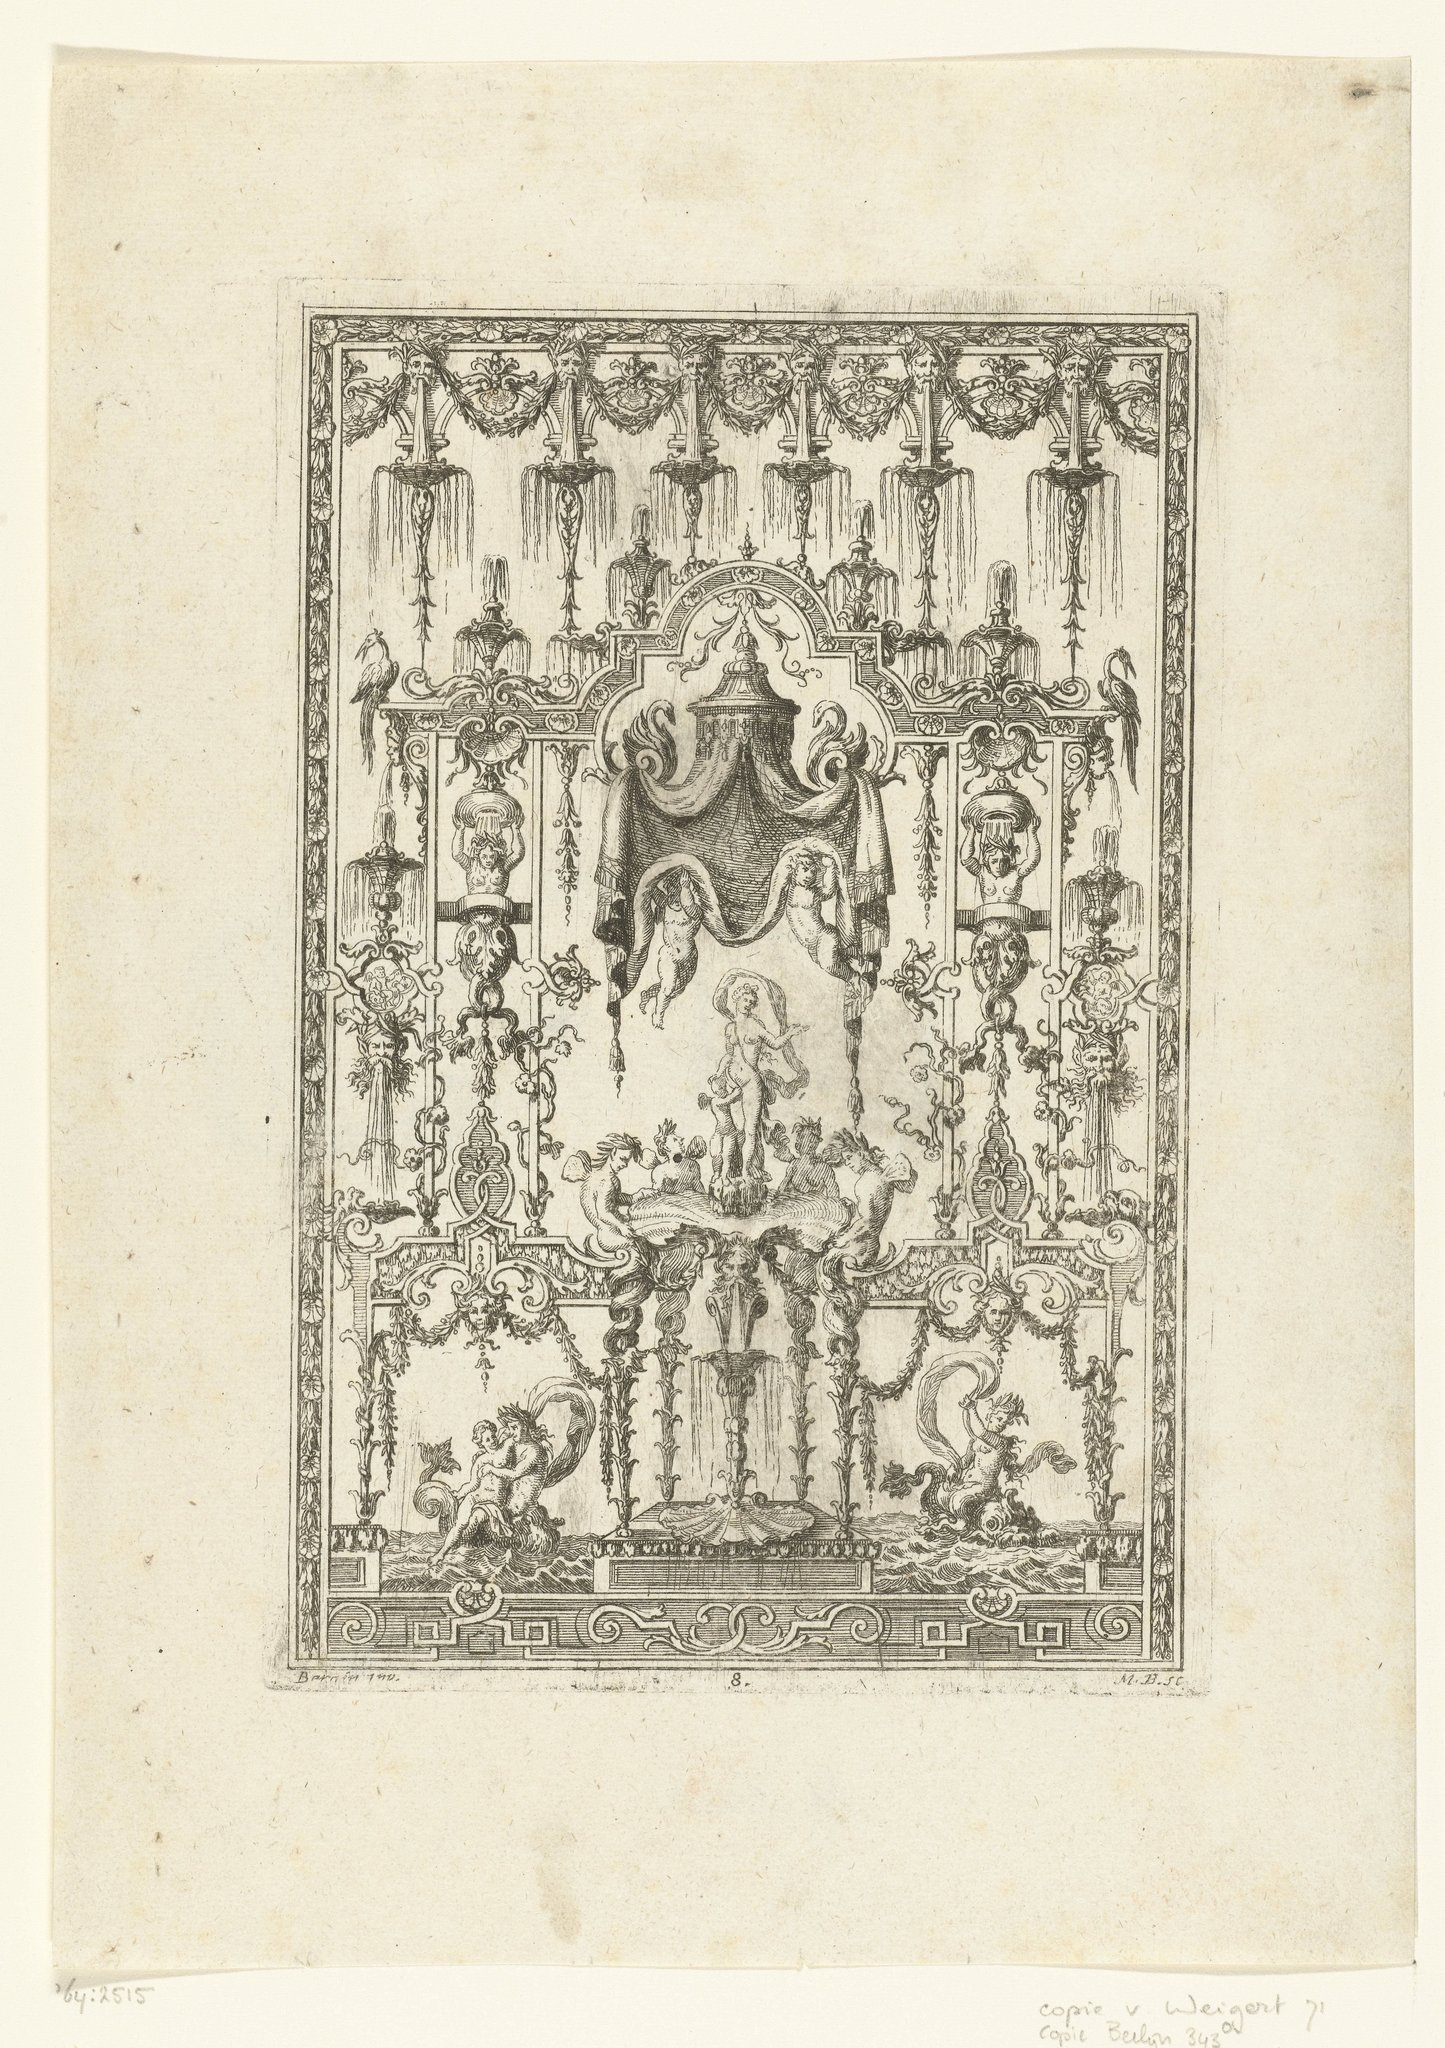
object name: print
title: Panelen met grotesken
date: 1675-1748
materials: paper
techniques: etching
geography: germany